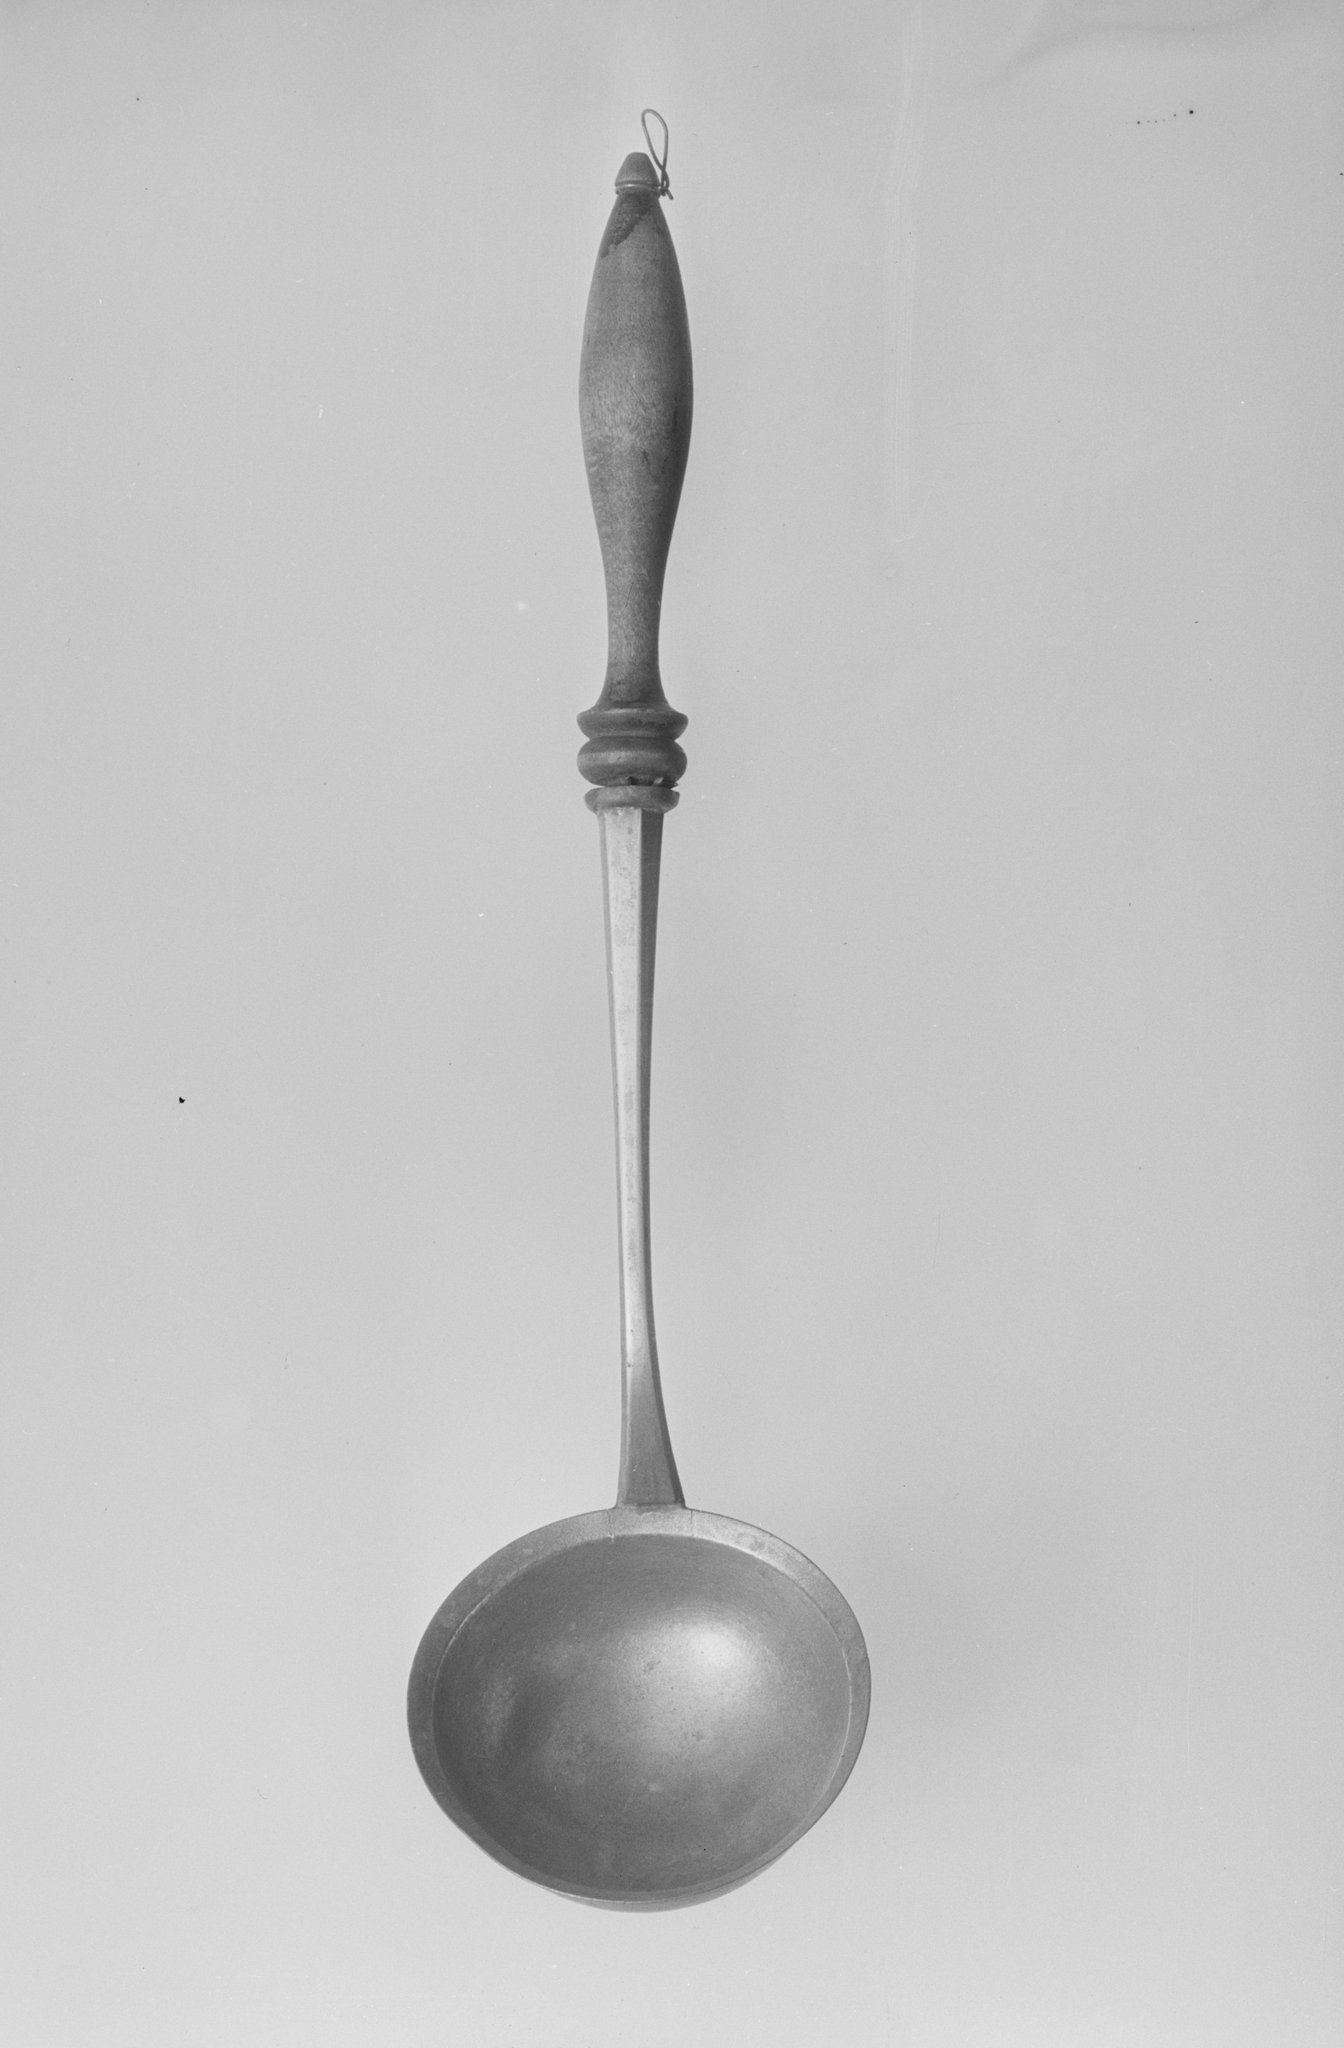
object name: ladle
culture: american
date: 1700-1800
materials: pewter, wood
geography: united states